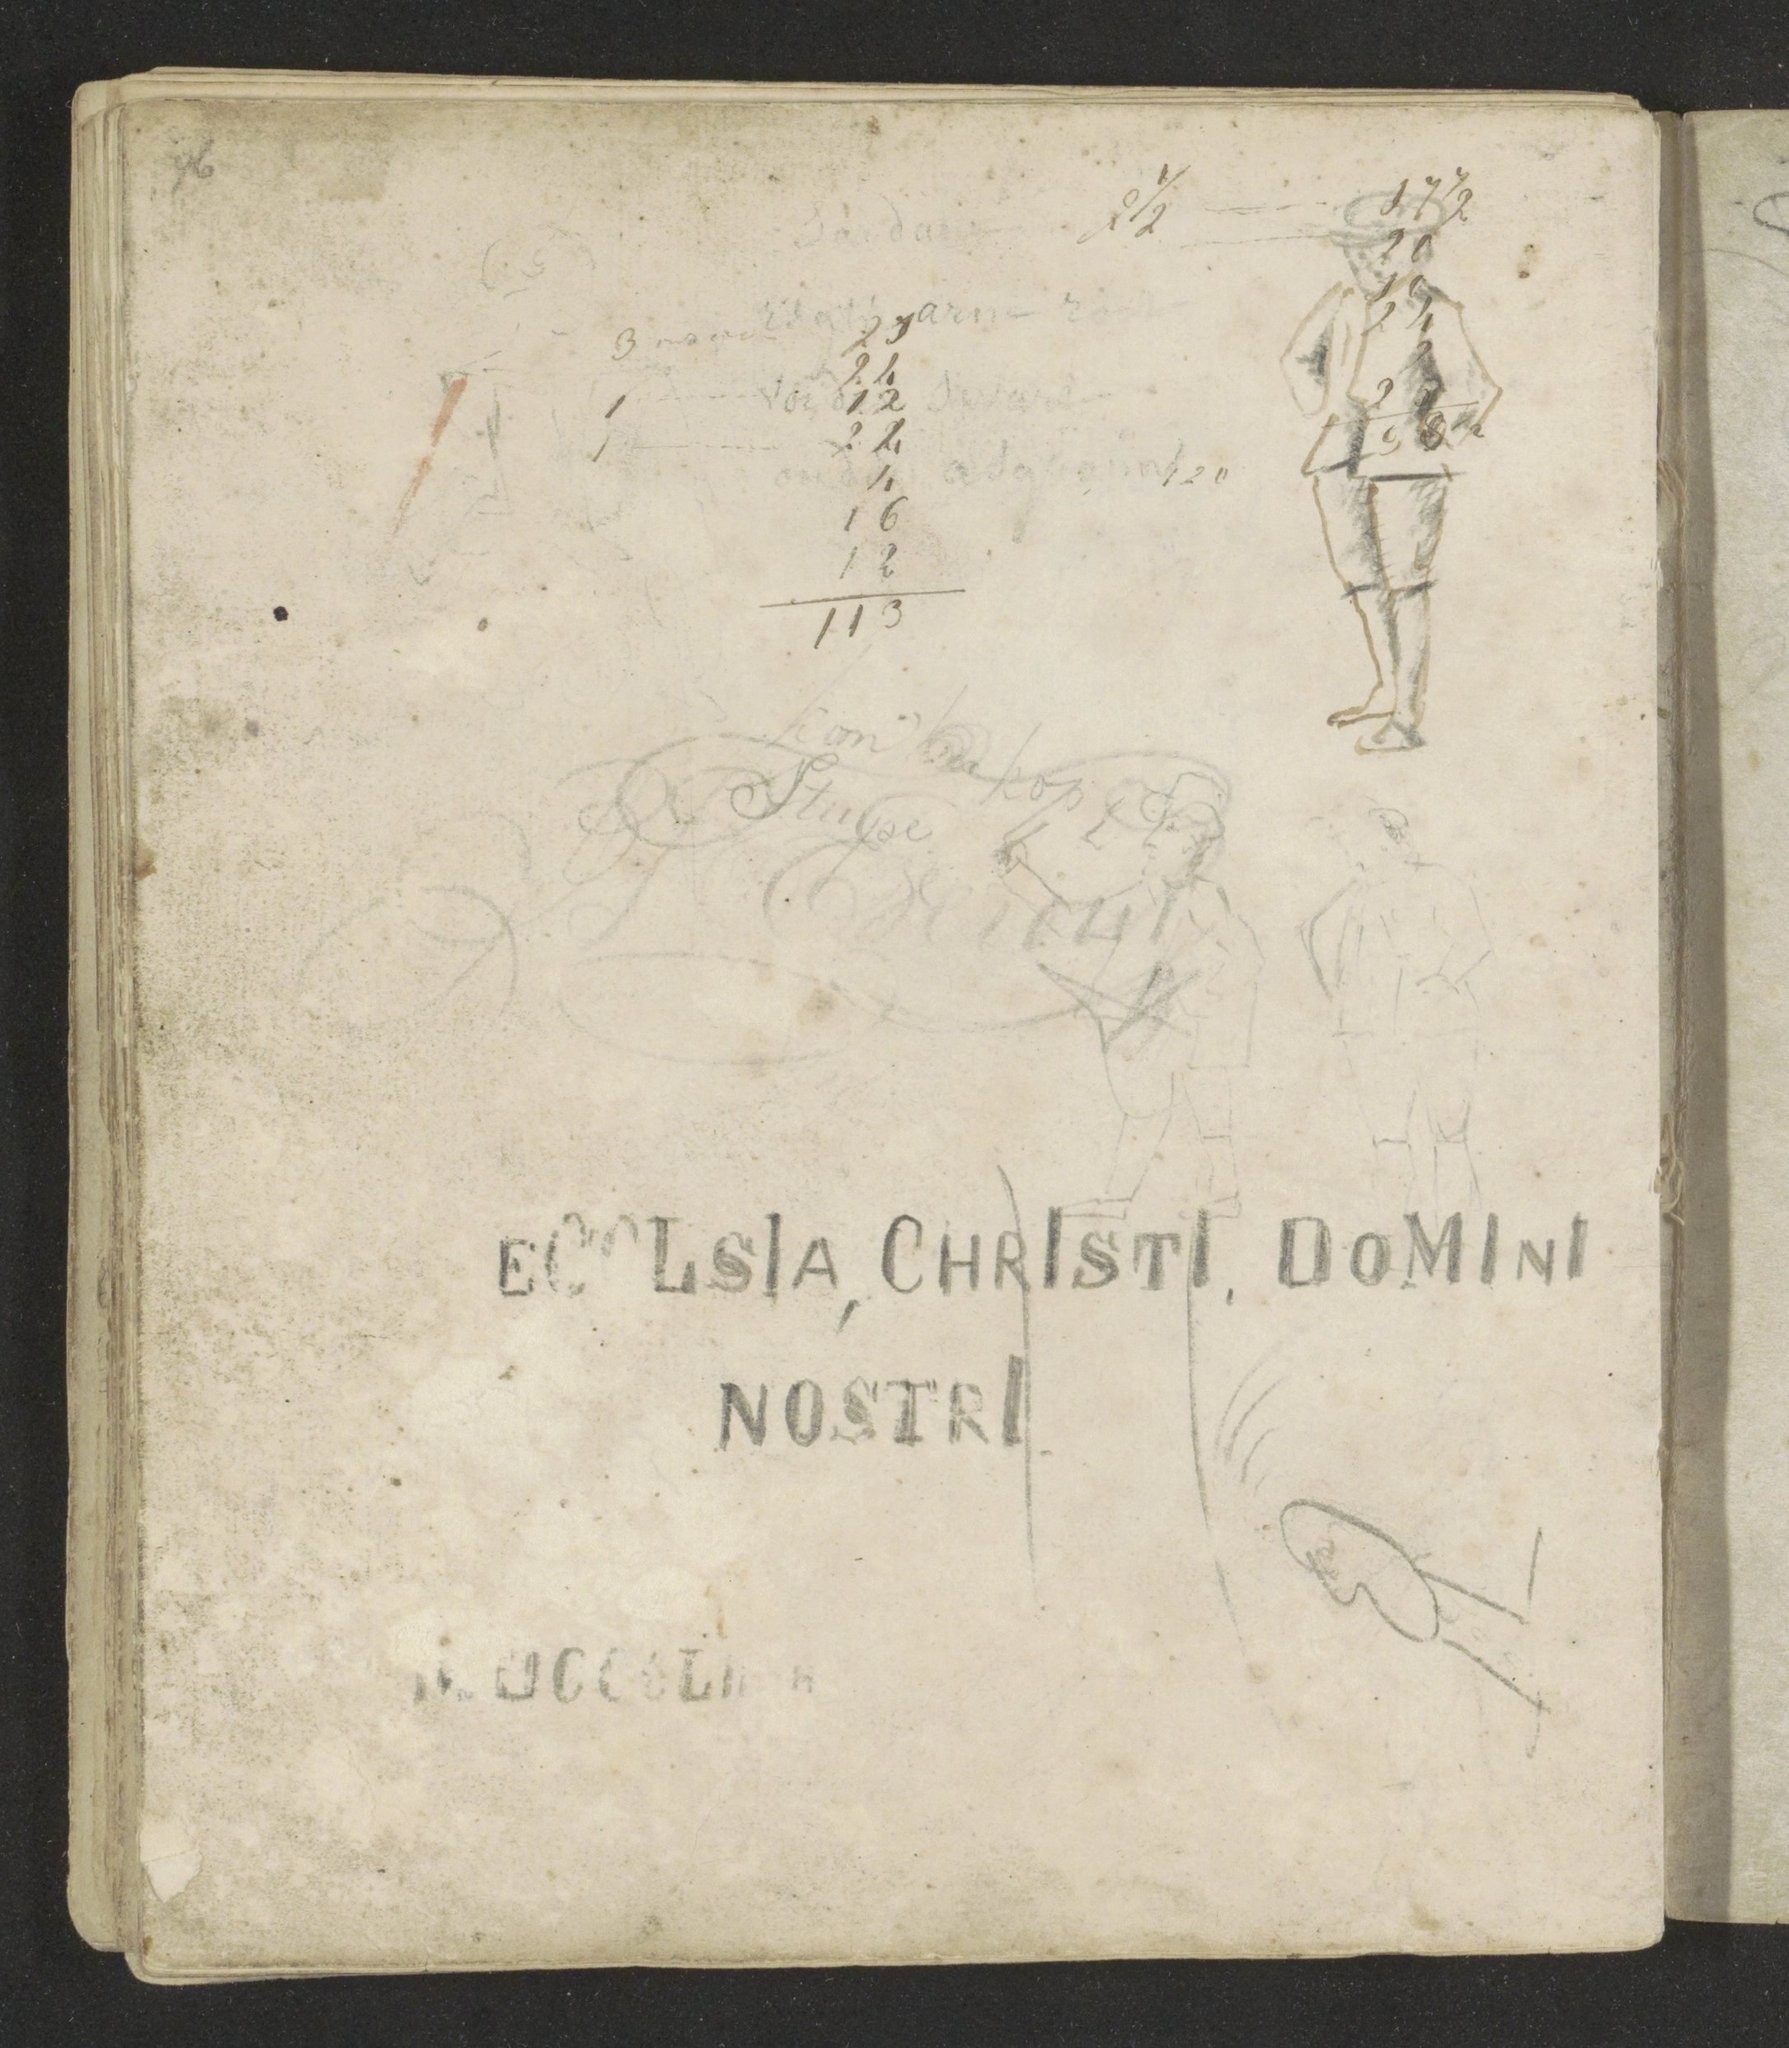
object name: sketchbook leaf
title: Figuurstudies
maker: Anonymous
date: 1840-1860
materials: ink, paper, pencil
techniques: pen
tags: standing figure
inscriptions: annotation: ‘.../ EC[...]LSIA CHRISTI DOMINI/ NOSTRI/ ...’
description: Bladzijde 96 uit een schetsboek met 96 bladzijden.